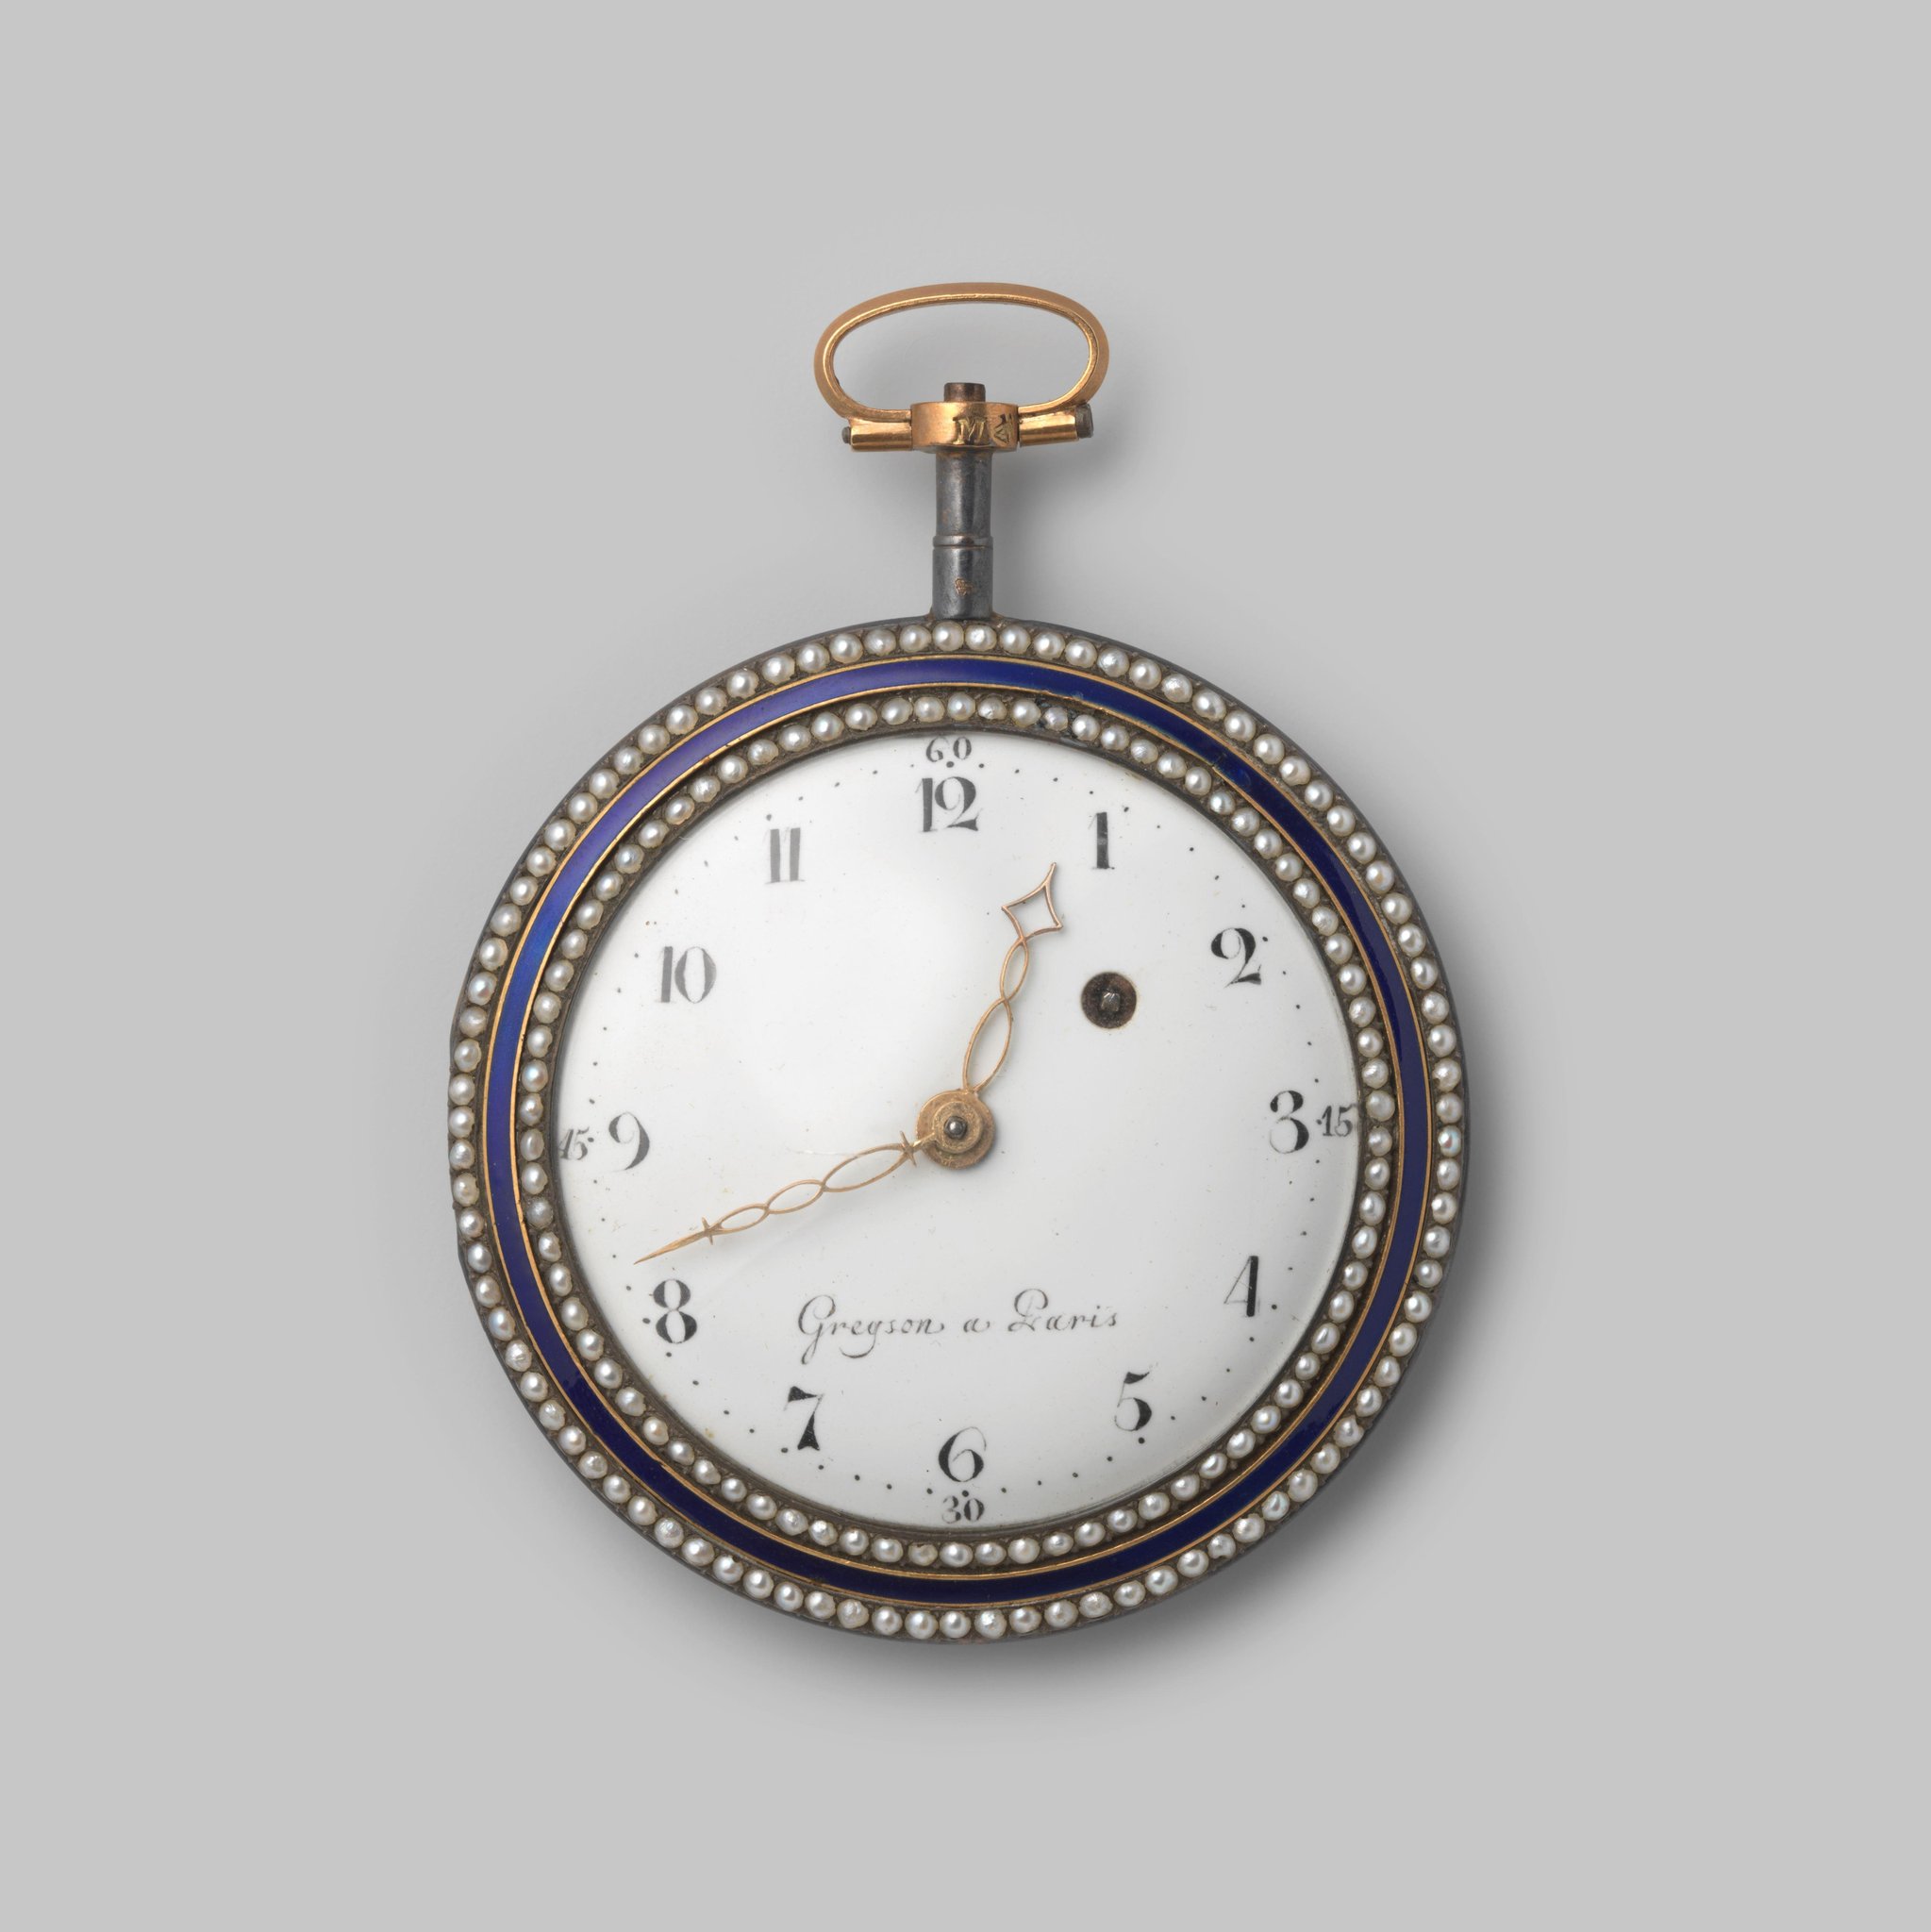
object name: jewellery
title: Horloge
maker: gregson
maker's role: clockmaker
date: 1810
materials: gold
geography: paris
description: Herenhorloge van goud met emailschilderingen. Op de achterbodem een emailschildering, voorstellende een meisje met bloemen.